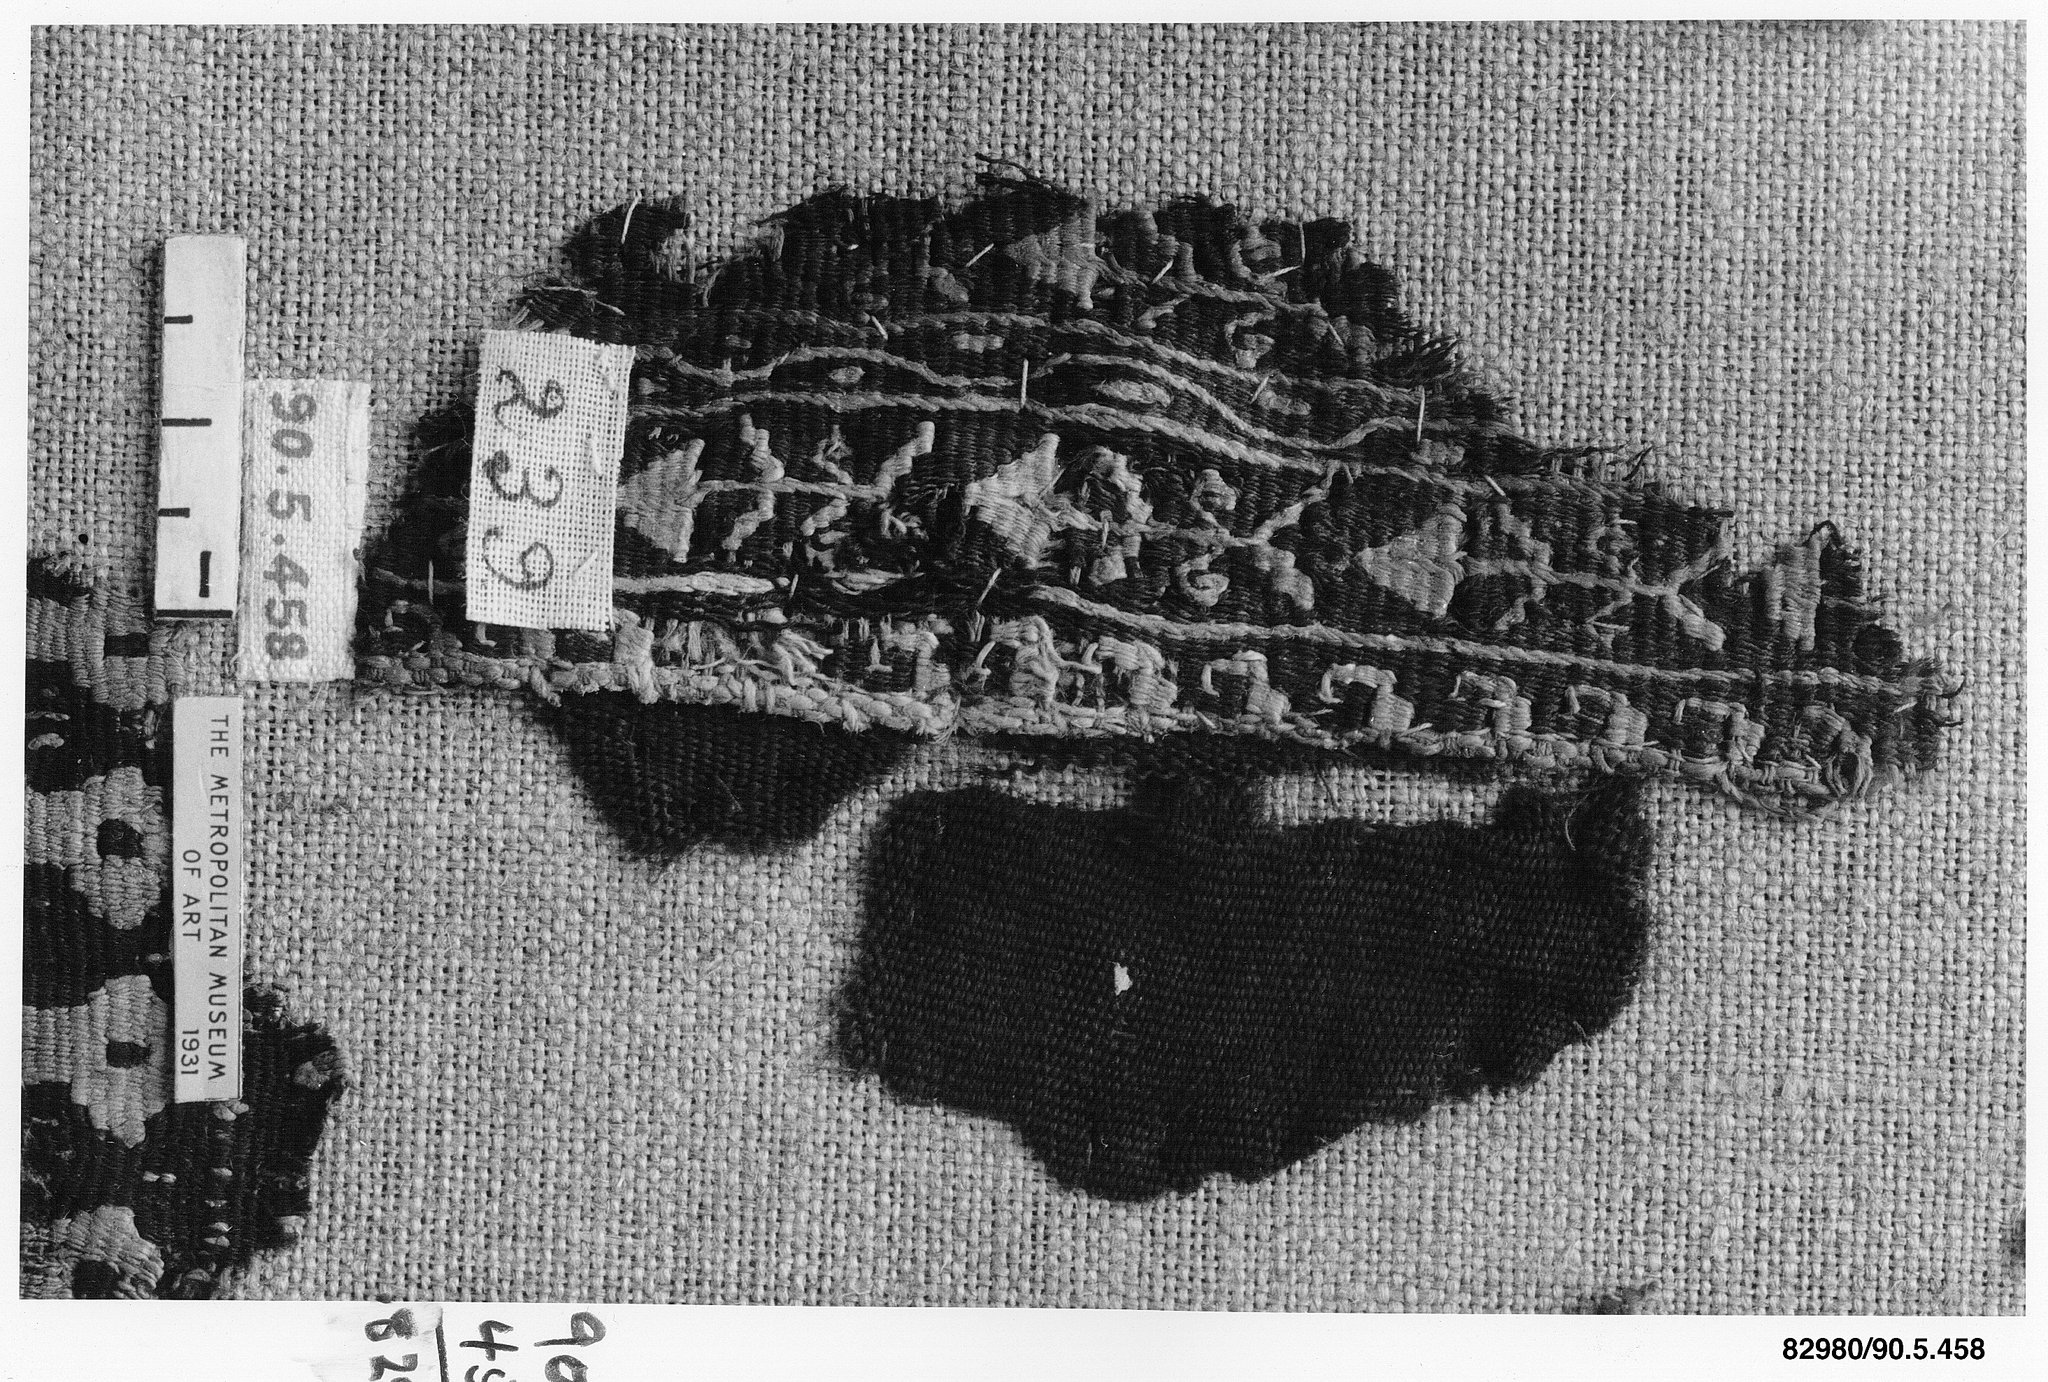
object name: textile fragment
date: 401-500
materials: linen, wool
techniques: weave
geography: egypt